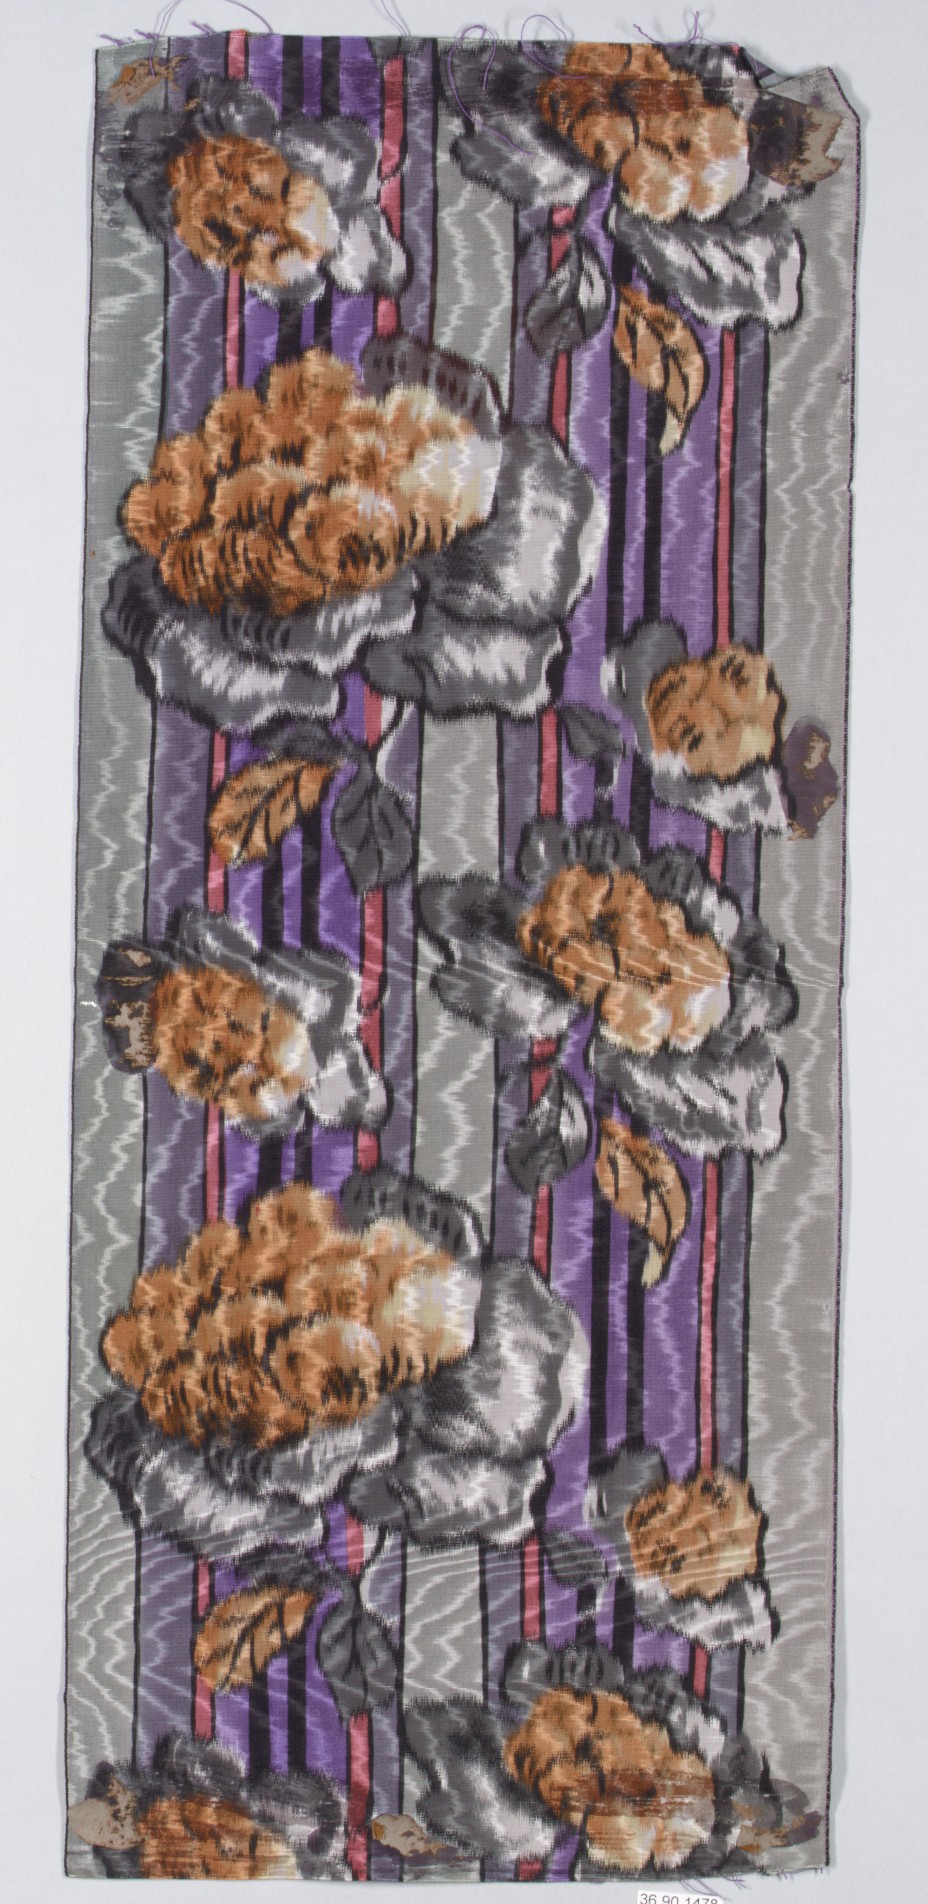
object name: ribbon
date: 1801-1900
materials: silk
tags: flowers